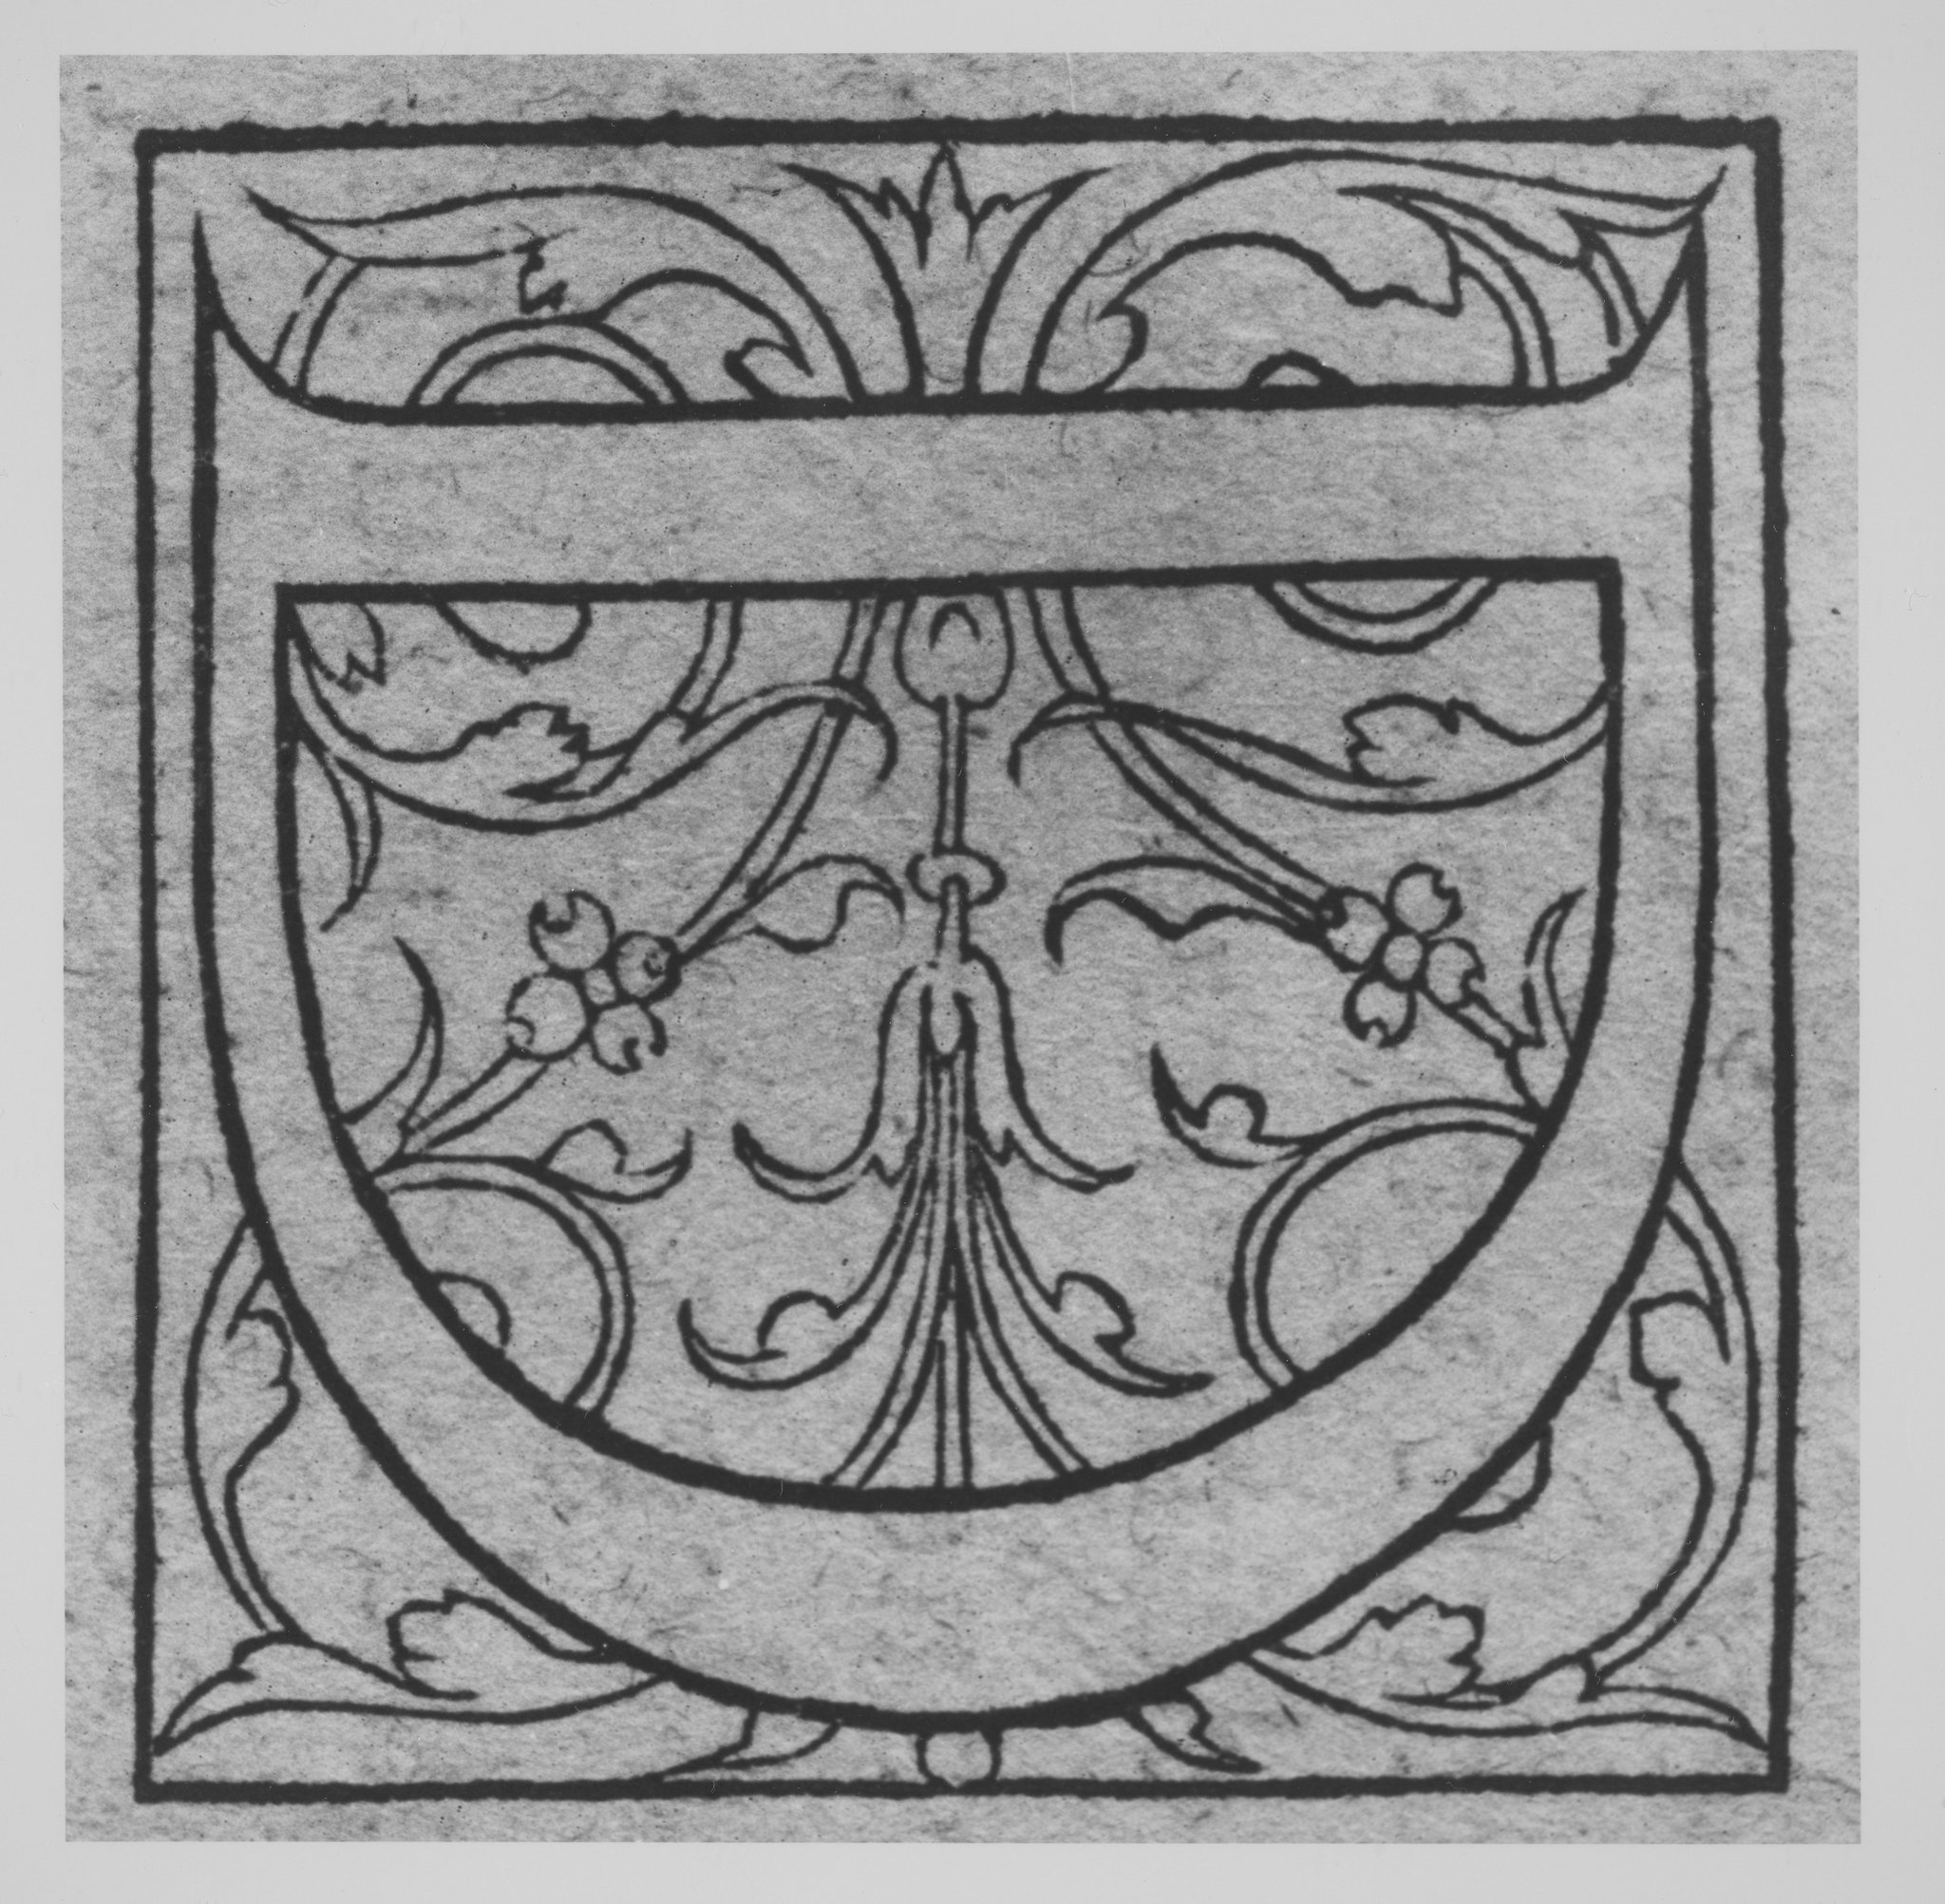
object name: book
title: Histoire de Primaleon de Grece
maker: pasquier le tellier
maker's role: printer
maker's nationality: french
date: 1550